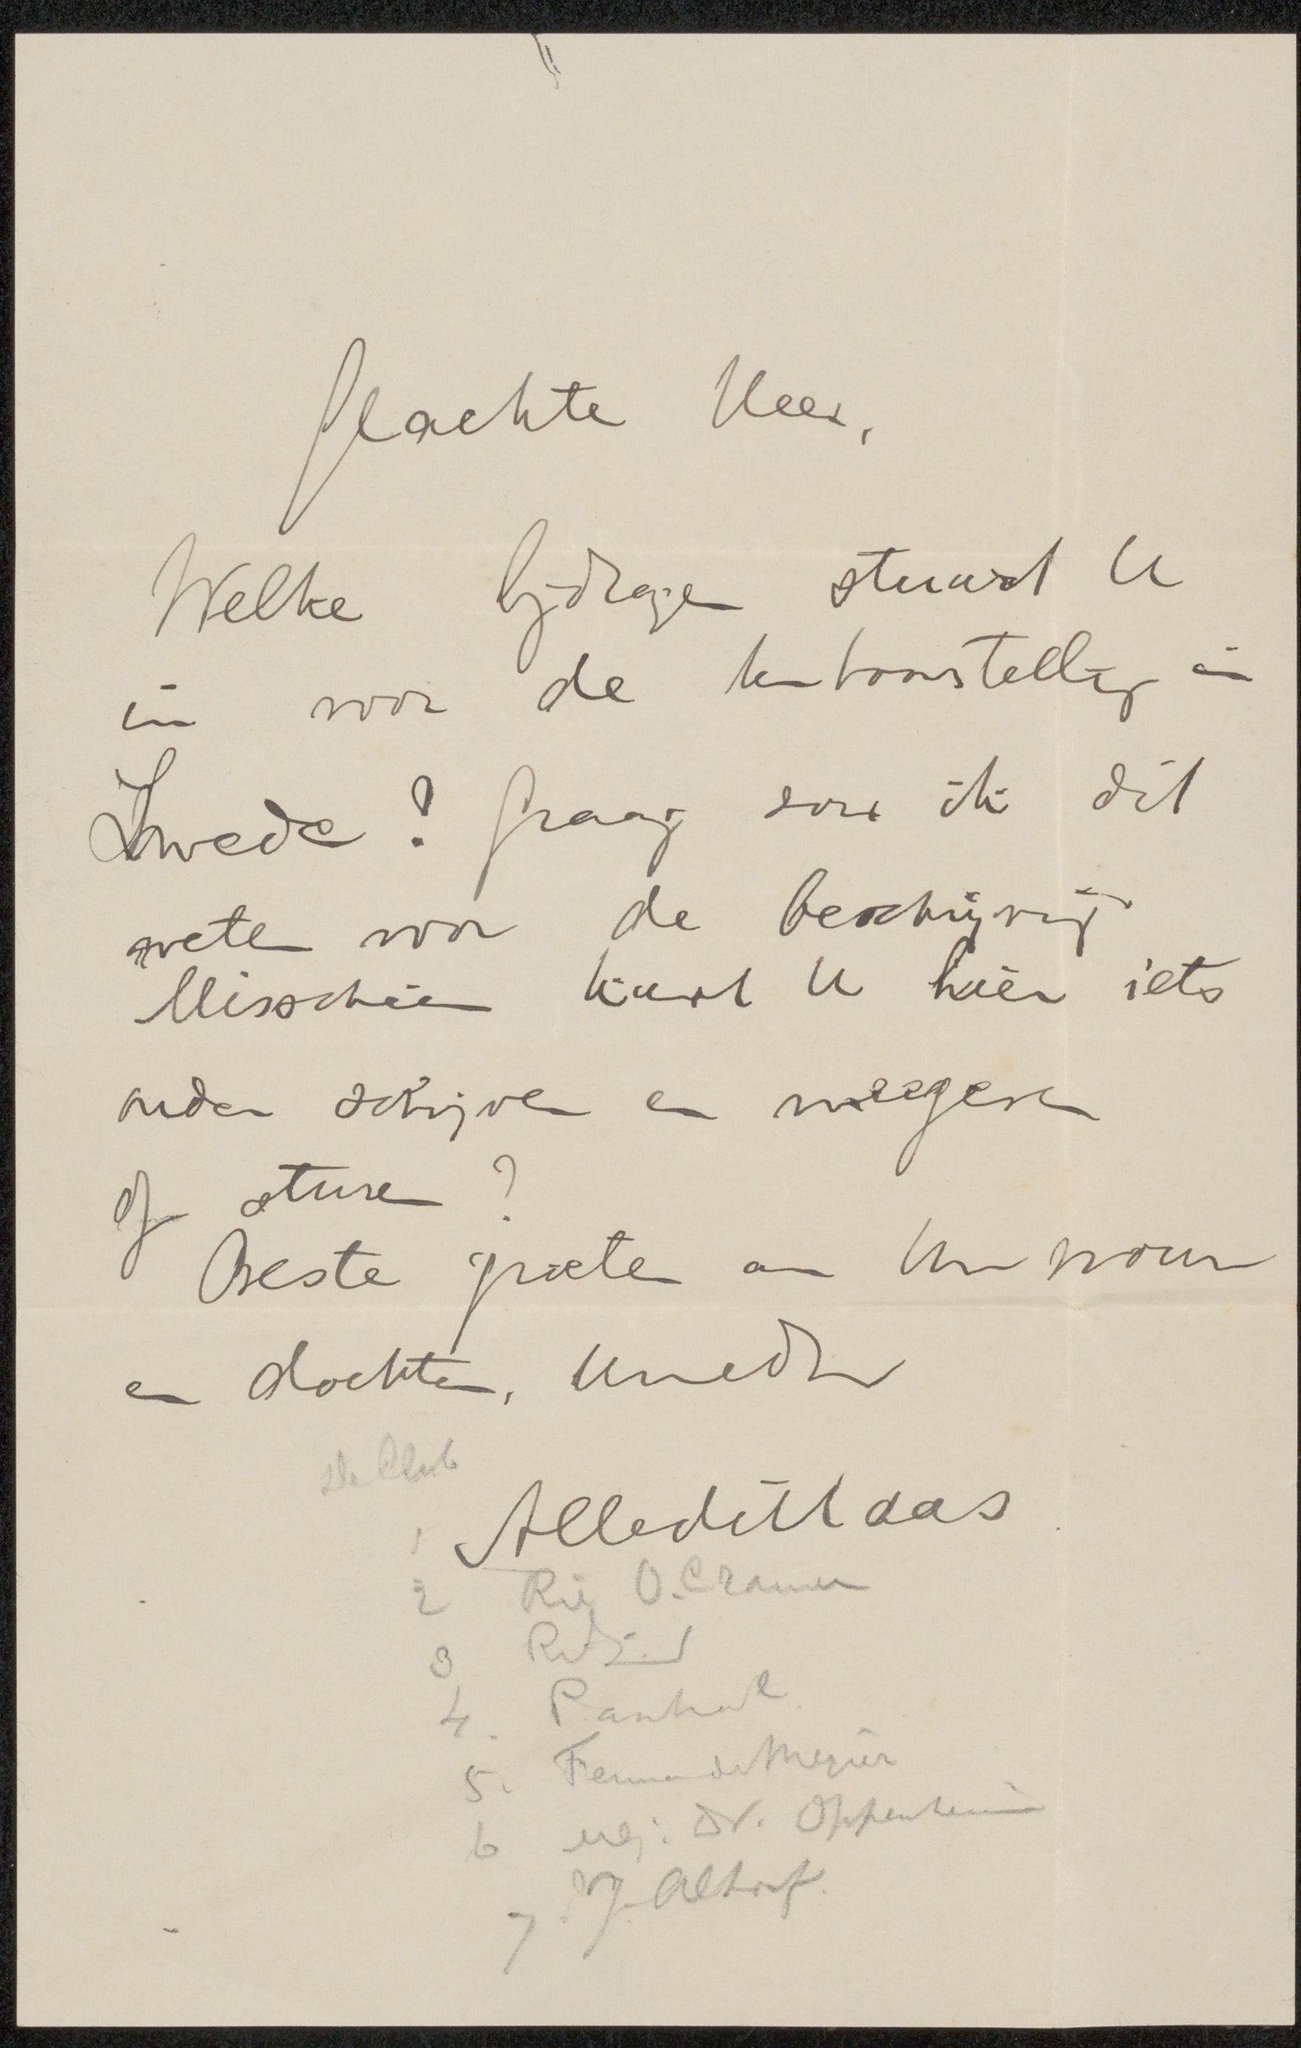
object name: letter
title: Brief aan Philip Zilcken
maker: albertine draaijer-de haas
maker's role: kunstcriticus, schrijver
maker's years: 1875-1952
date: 1885-1952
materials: ink, paper, pencil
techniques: pen, writing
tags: the hague, painter, philip zilcken, exhibition ~ art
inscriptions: collector's mark: ‘RPK’